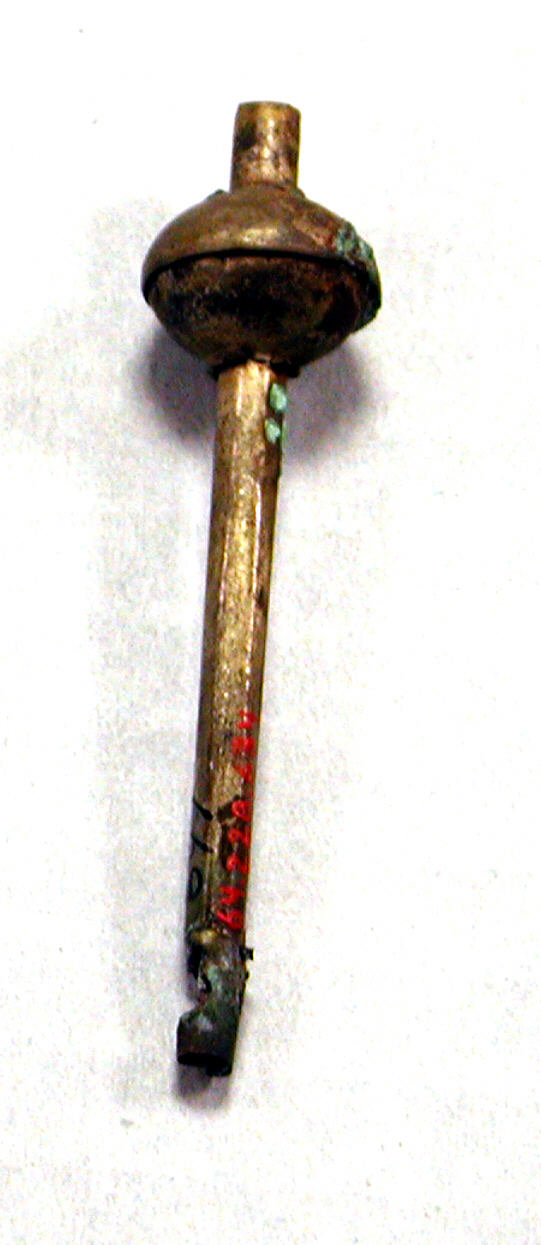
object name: scepter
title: Hammered Silver Miniature Scepter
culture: peruvian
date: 701-1566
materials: gilt, silver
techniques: hammering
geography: peru